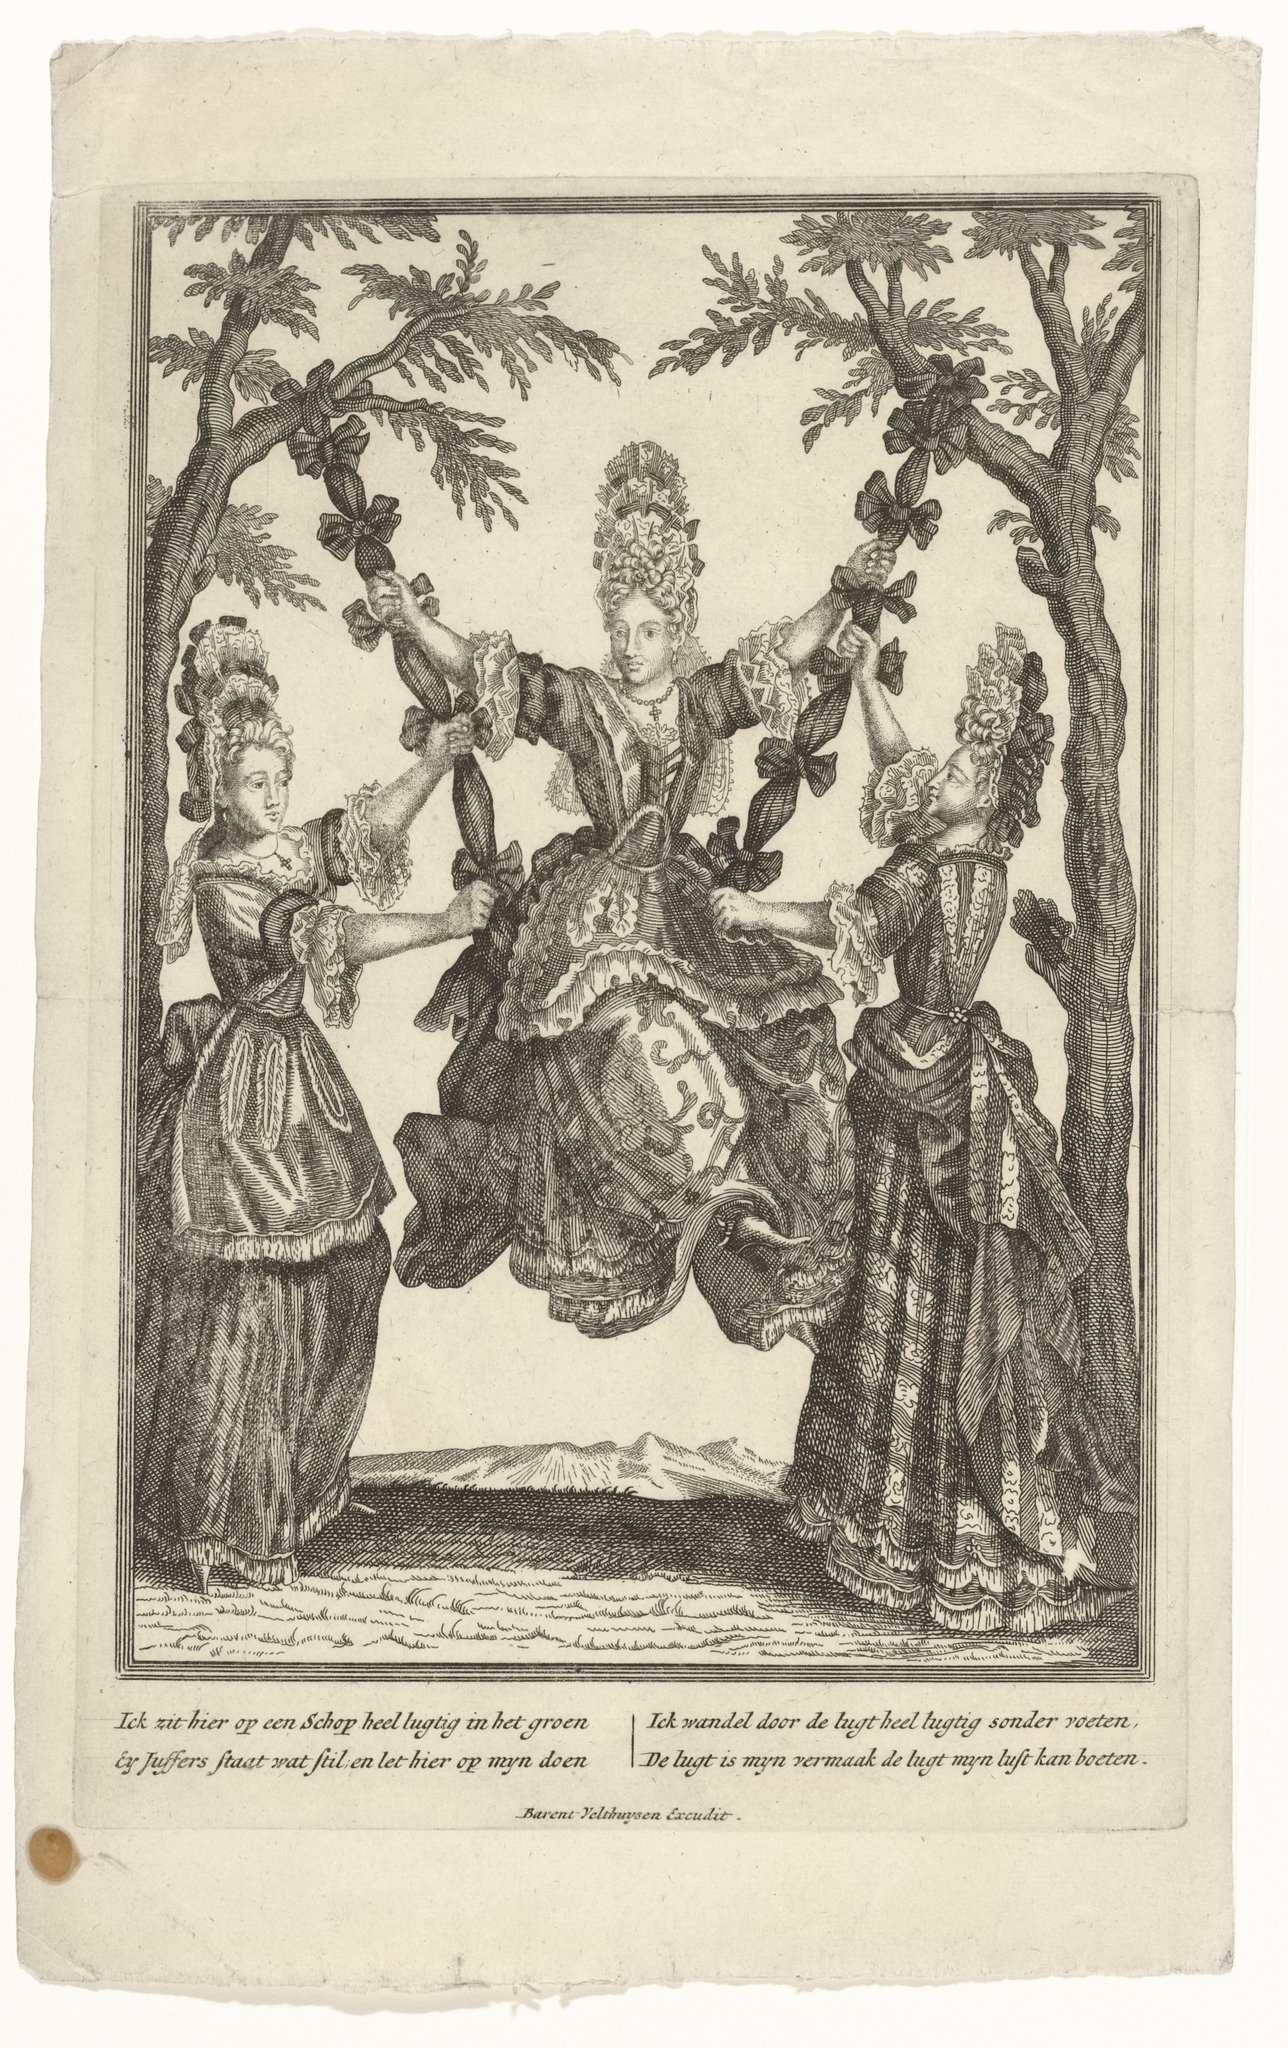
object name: costume print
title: Dame op schommel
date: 1680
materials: paper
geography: amsterdam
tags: fashion plates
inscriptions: address: ‘Barent Veldhuysen Excudit.’, caption: ‘Ick zit hier op een Schop heel lugtig in het groen / Ey juffers staat wat stil en let hier op myn doen / Ick wandel door de lugt heel liugtig sonder voeten / De lugt is myn vermaak de lugt mijn lust kan boeten.’